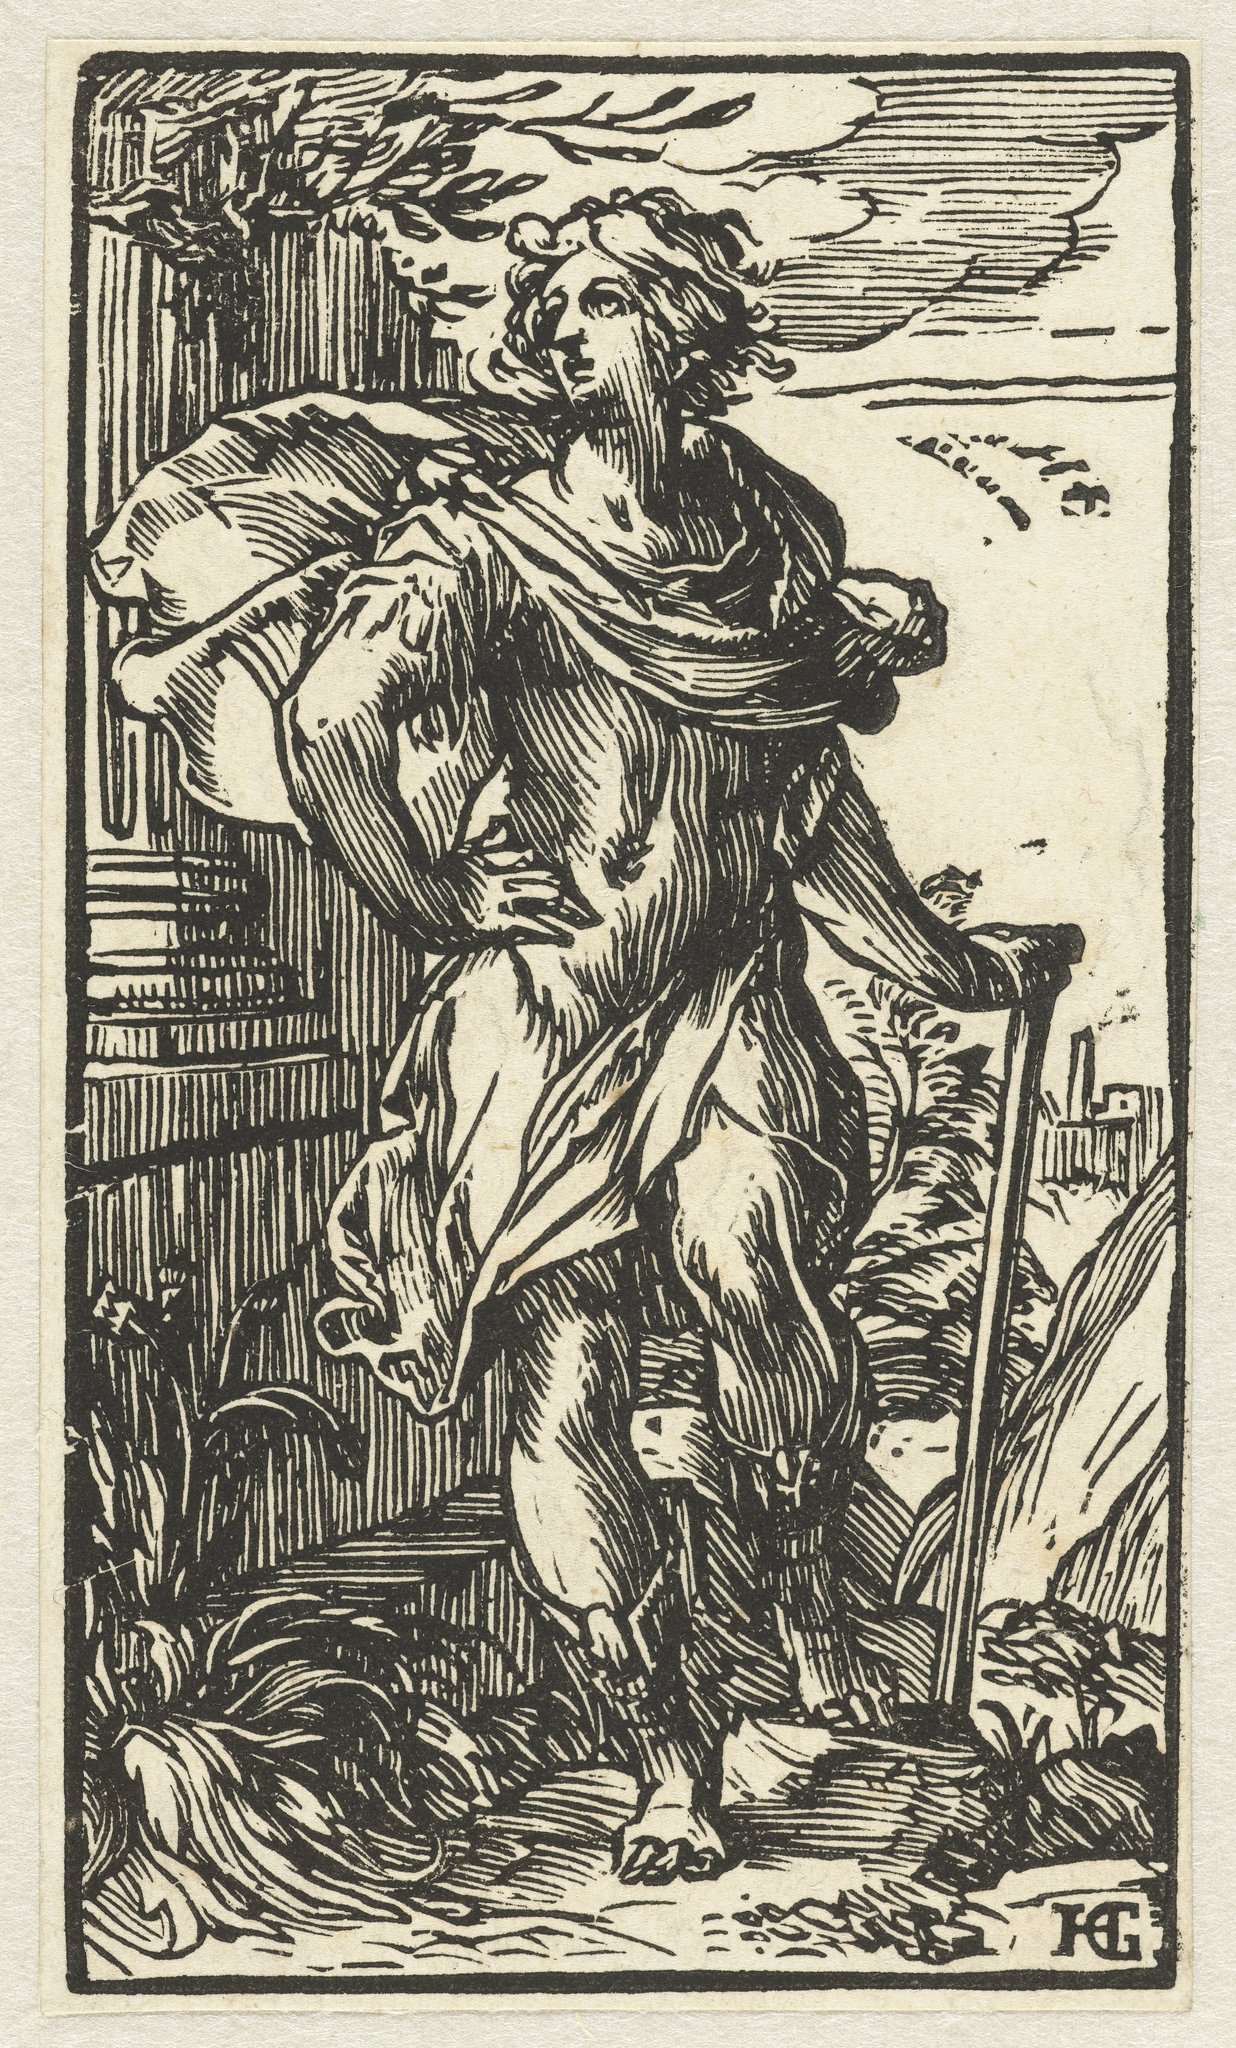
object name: print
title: Jongeman met wandelstok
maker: hendrick goltzius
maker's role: draughtsman, painter, print maker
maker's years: 1558-1617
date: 1596-1600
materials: paper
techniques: woodcut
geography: haarlem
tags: the (nude) human figure; 'corpo humano' (ripa) (+ young male (human being))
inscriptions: collector's mark: Lugt 2228, collector's mark: Lugt 240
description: Een man met kleding aan die wappert in de wind en een wandelstok in de linkerhand, staand bij een huis of gebouw.